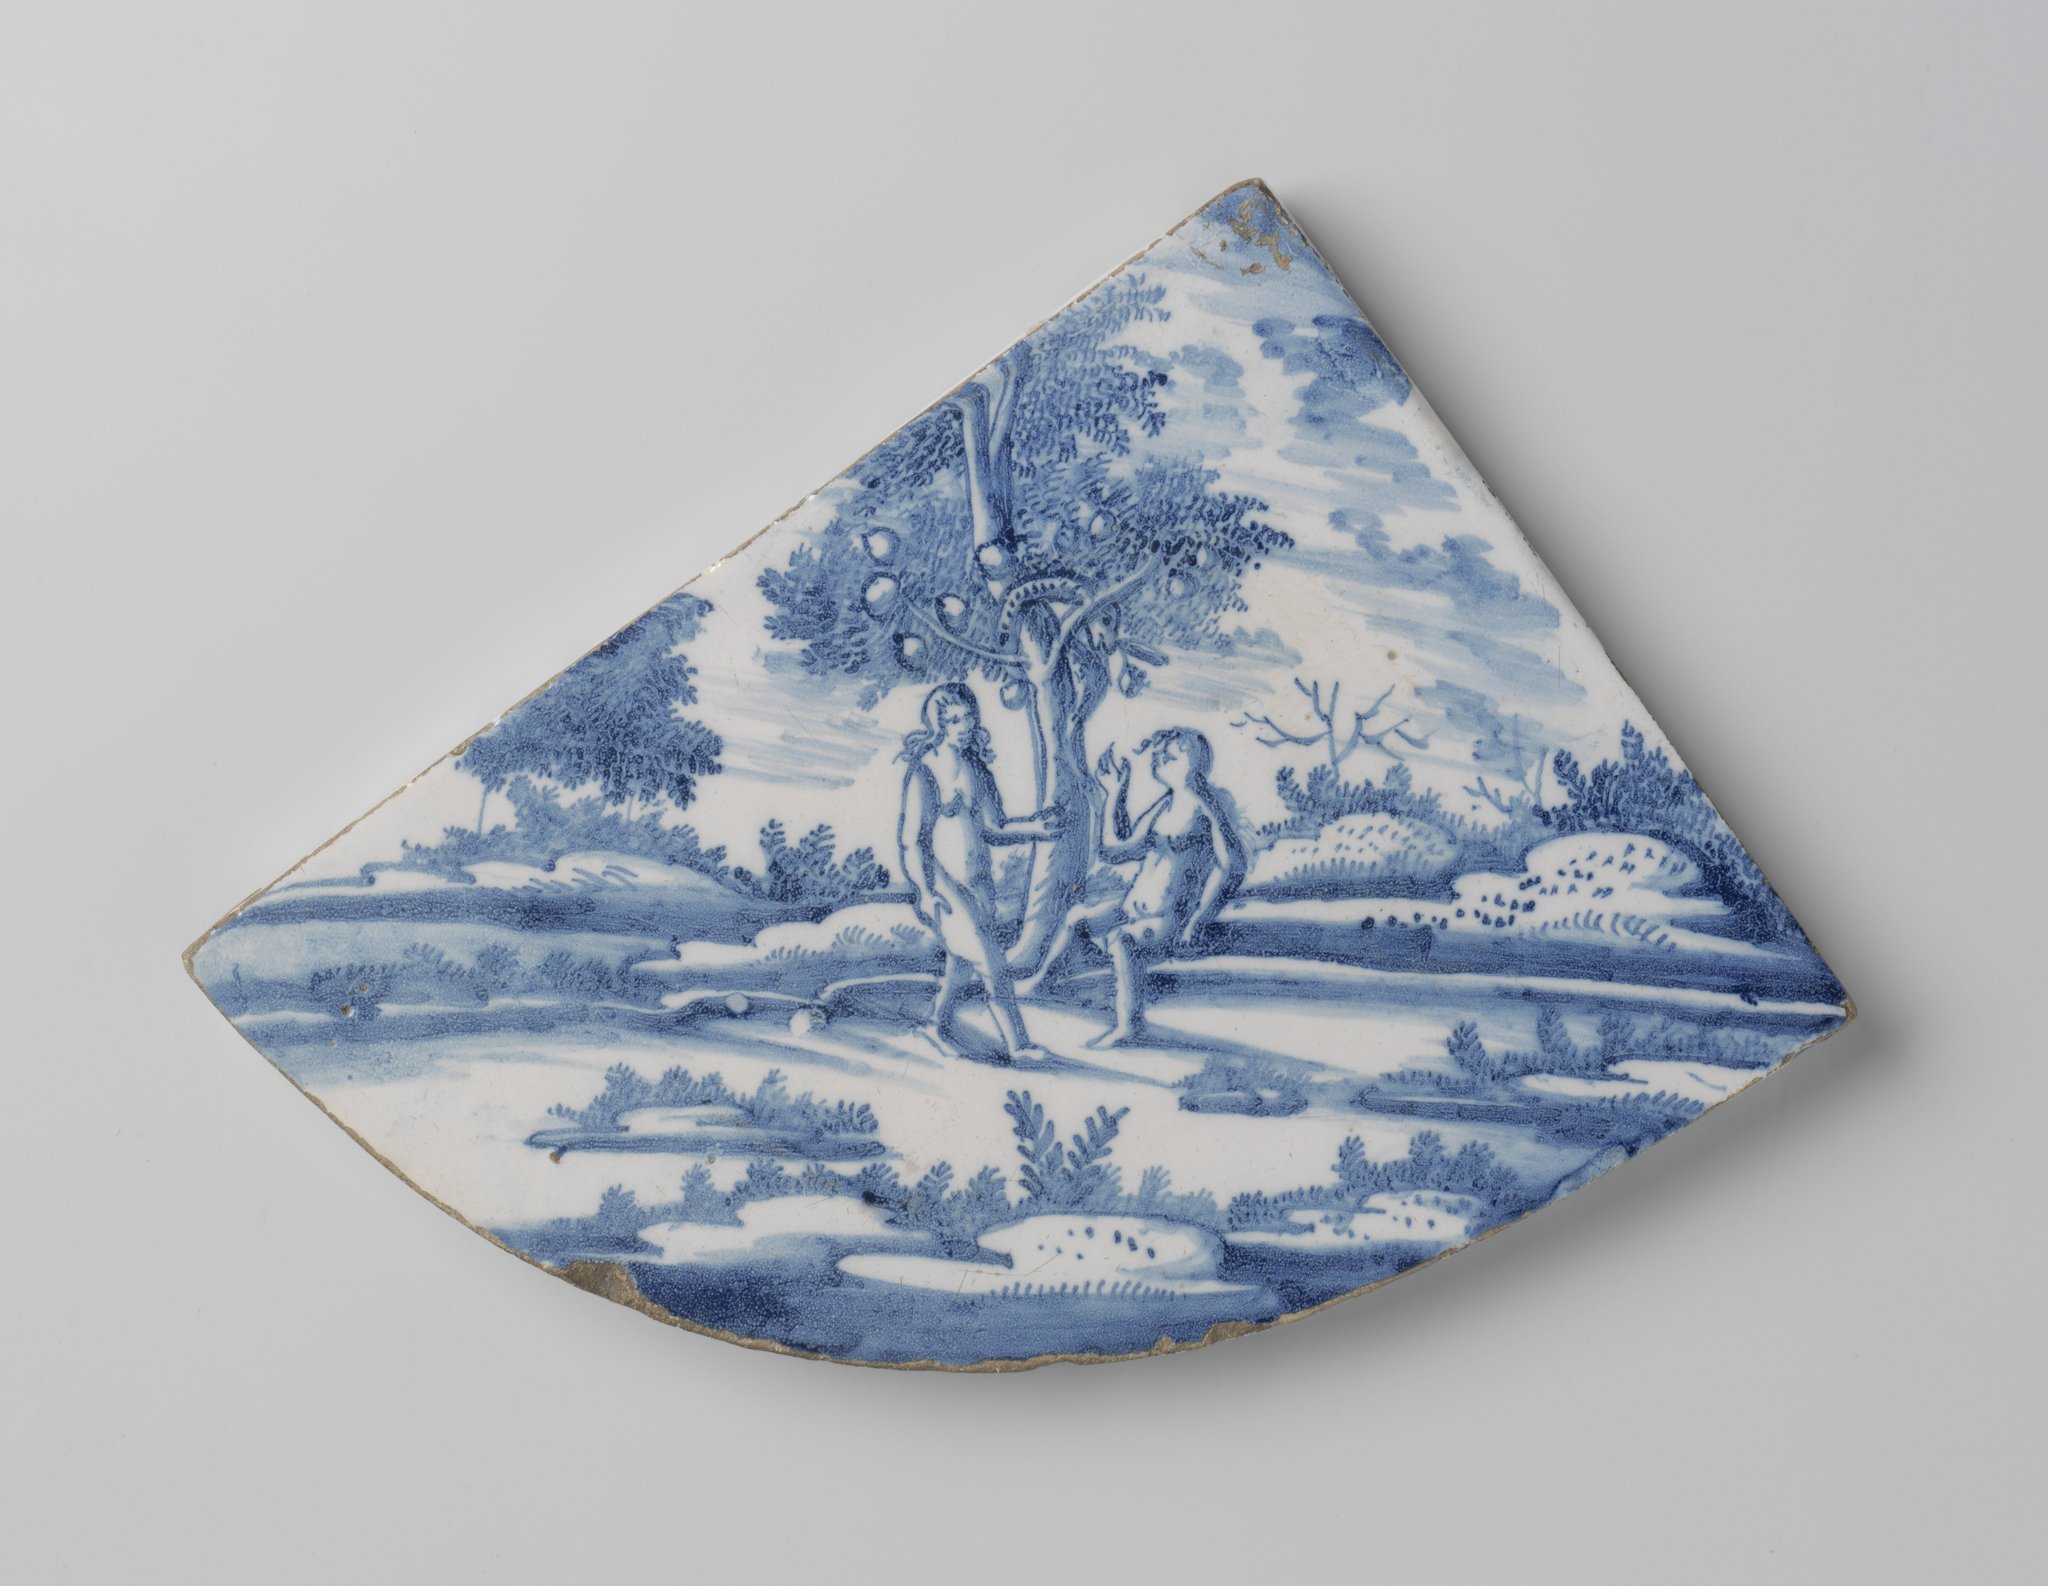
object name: tile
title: Etagère tegel met voorstelling Adam en Eva in het Paradijs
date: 1720-1770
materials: faience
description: Etagère tegel van faience. Blauw beschilderd met een voorstelling van Adam en Eva in het Paradijs.